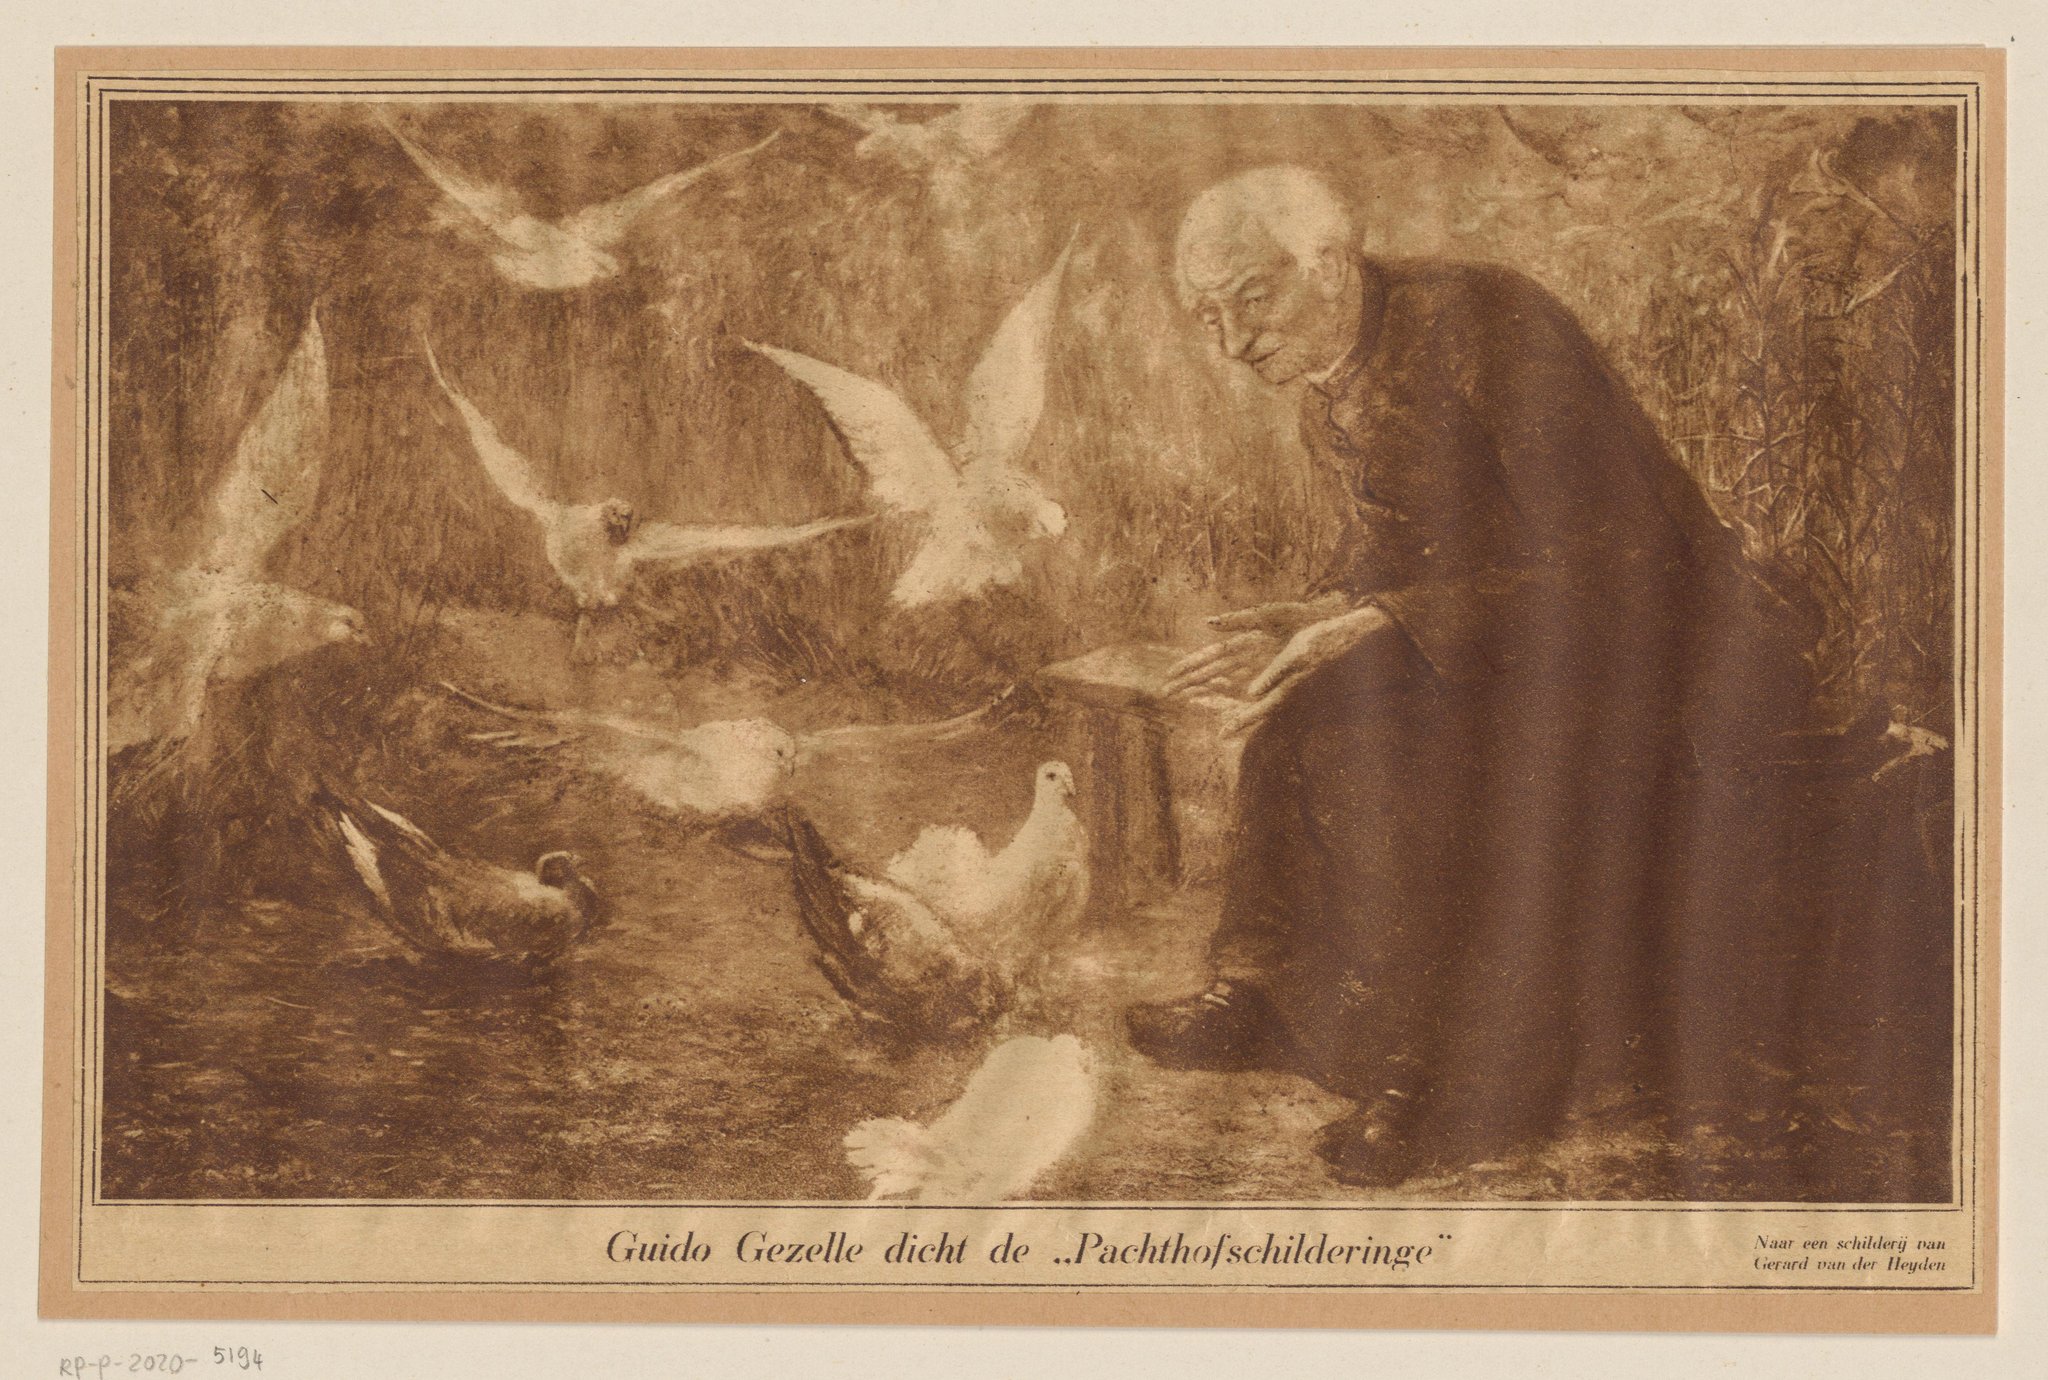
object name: photomechanical print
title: Portret van Guido Gezelle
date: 1895-1930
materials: paper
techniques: letterpress printing, rotogravure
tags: guido gezelle, historical persons, writer, poet, author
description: Tekst in het Nederlands in de ondermarge.